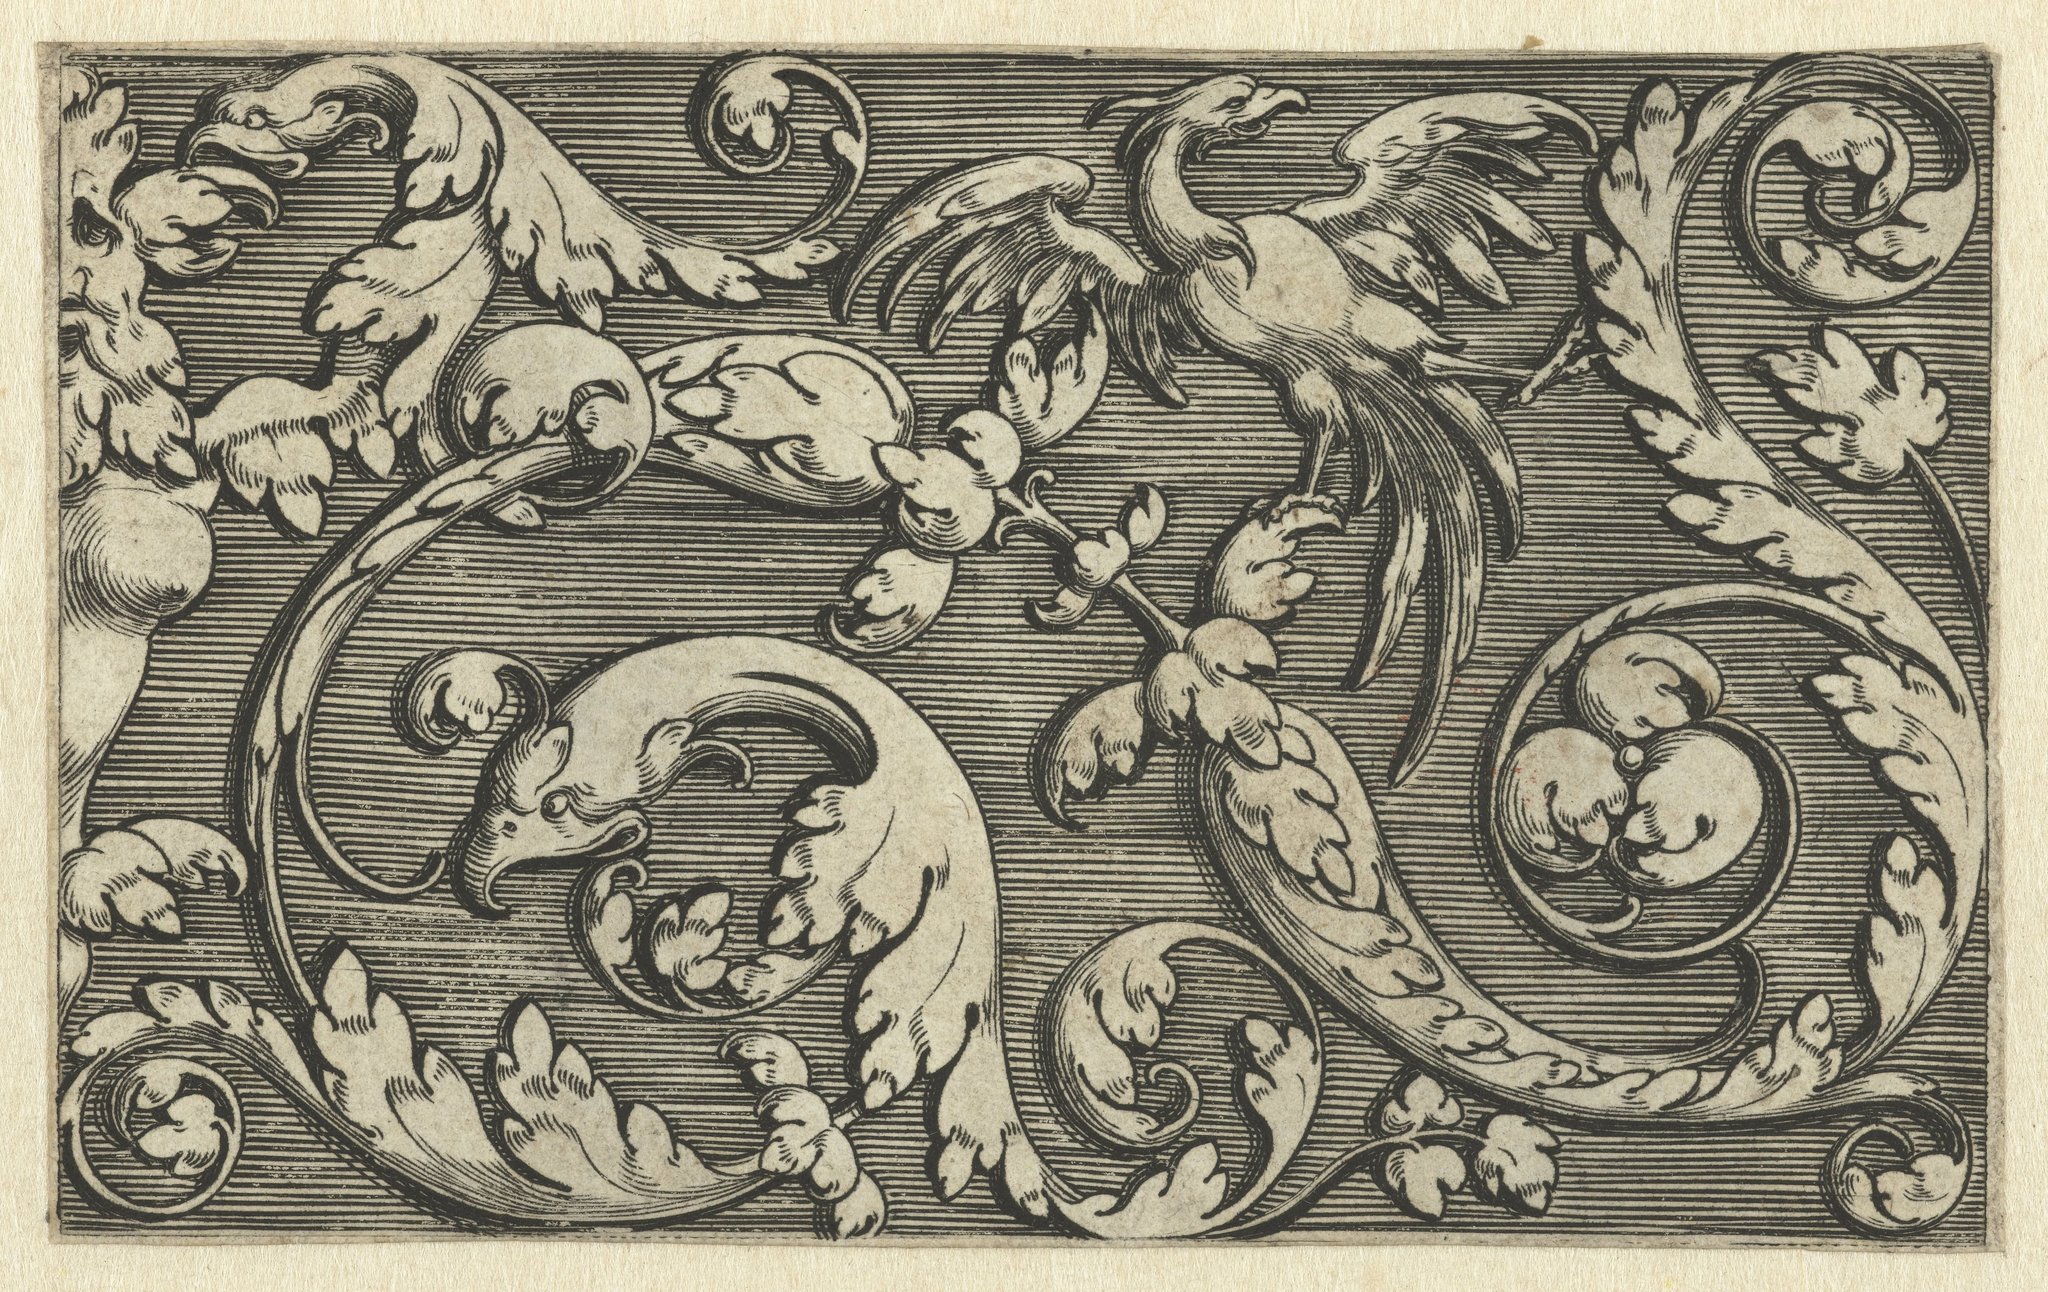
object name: ornament print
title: Ornament met vogel en vogelkoppen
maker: monogrammist ig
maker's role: print maker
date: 1522-1530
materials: paper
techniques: engraving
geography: low countries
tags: fabulous animals ~ ornamental birds, ornamental plants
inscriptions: collector's mark: Lugt 240